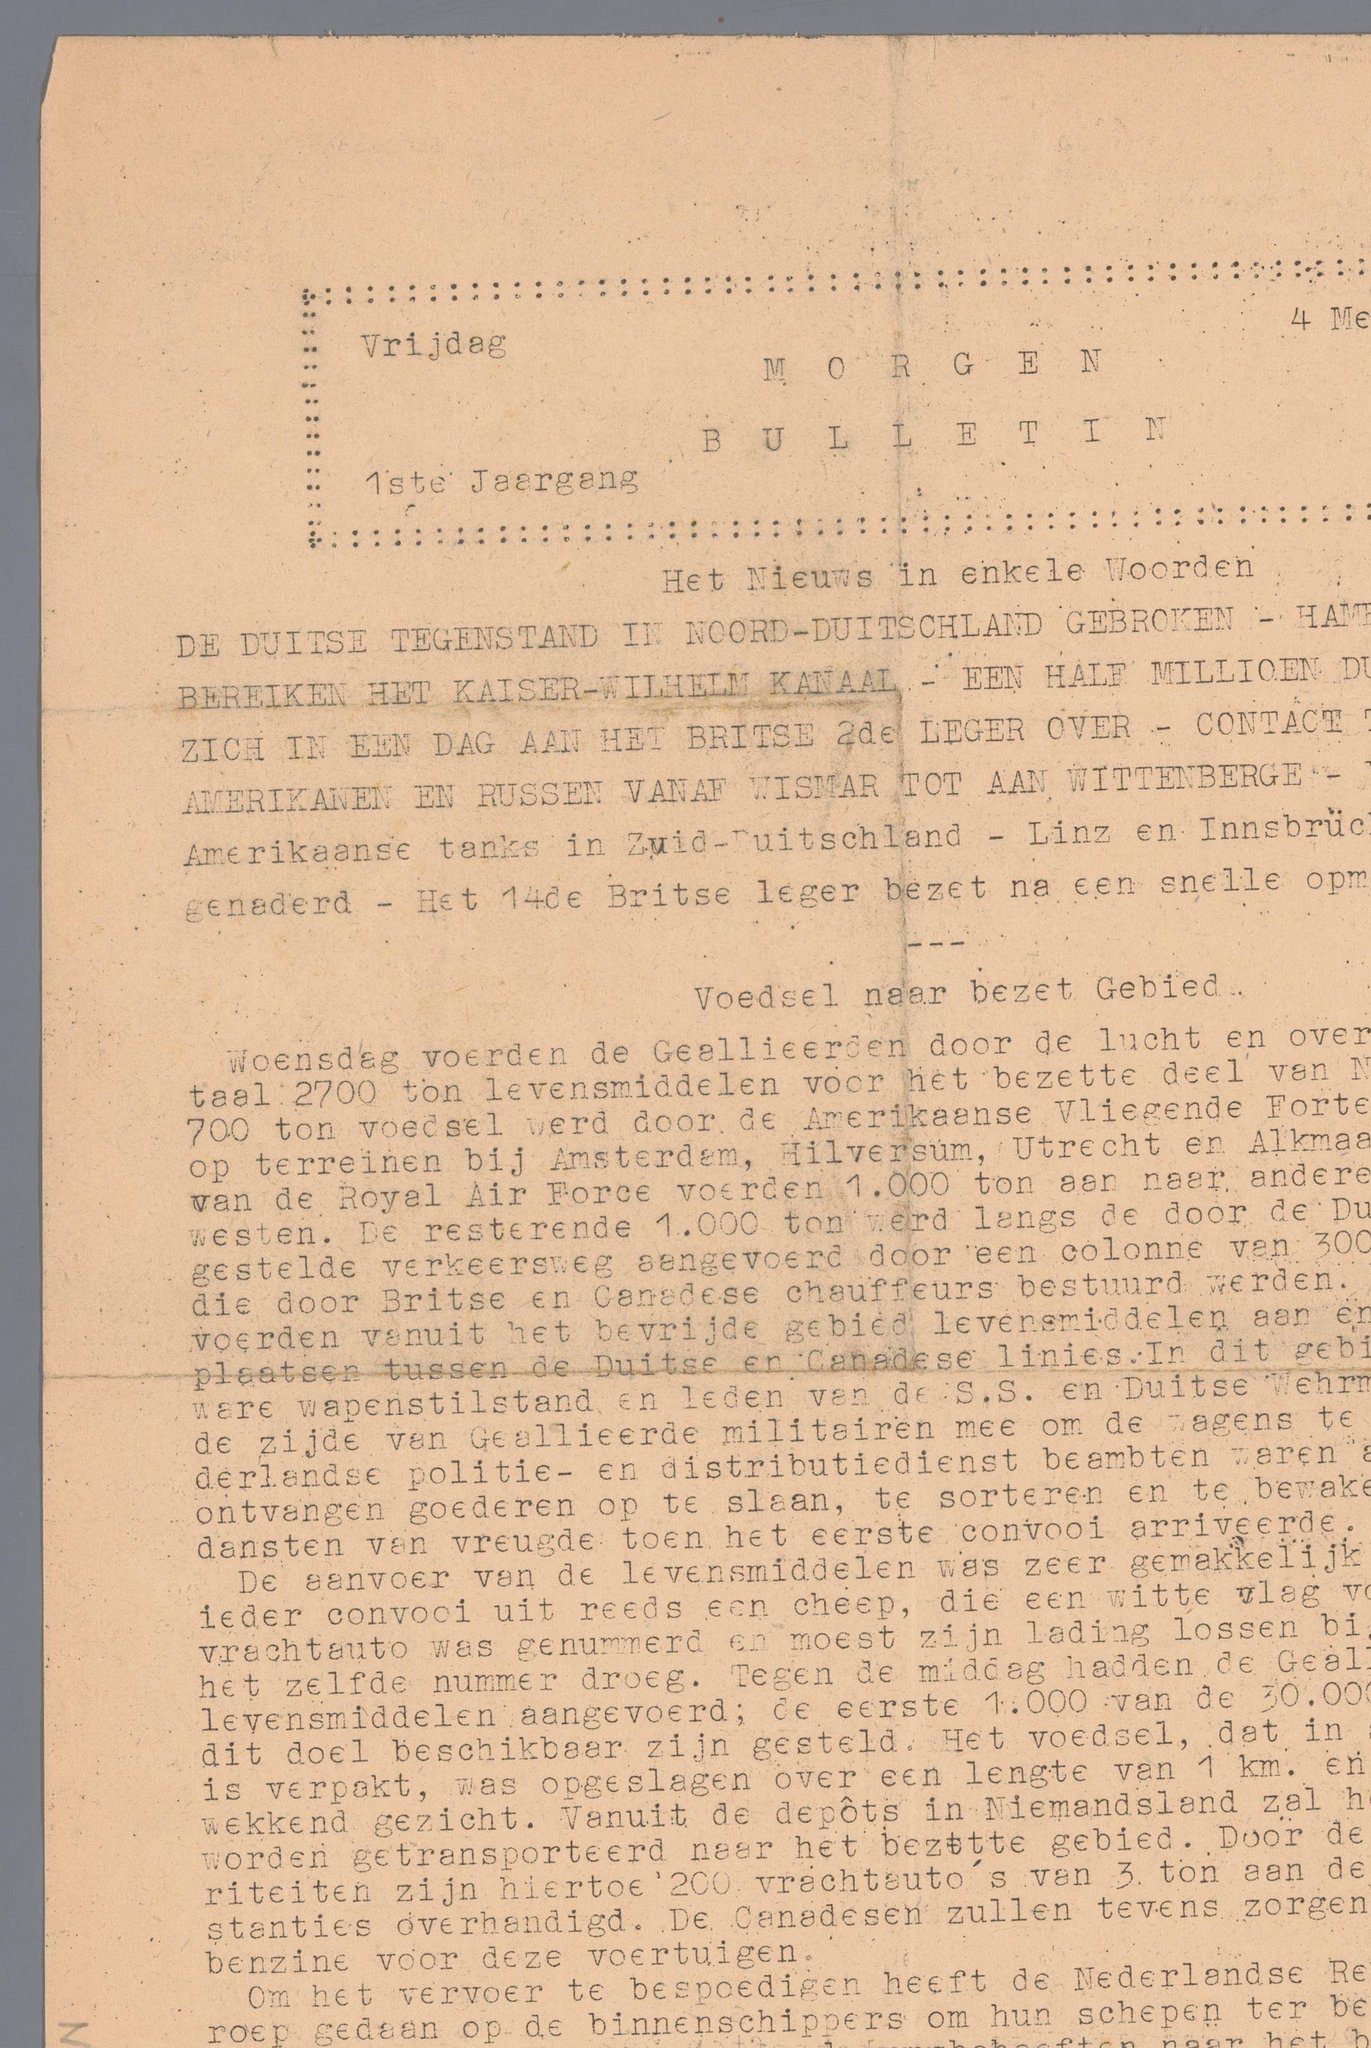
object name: sheet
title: Morgen Bulletin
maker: p. duyff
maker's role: schrijver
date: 1945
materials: paper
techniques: mimeography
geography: alkmaar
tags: europe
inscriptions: date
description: Nummer van illegaal blad Morgen bulletin, 1ste jaargang, nr. 184, 4/5/1945, 2 pp. Gedateerd: r.b.